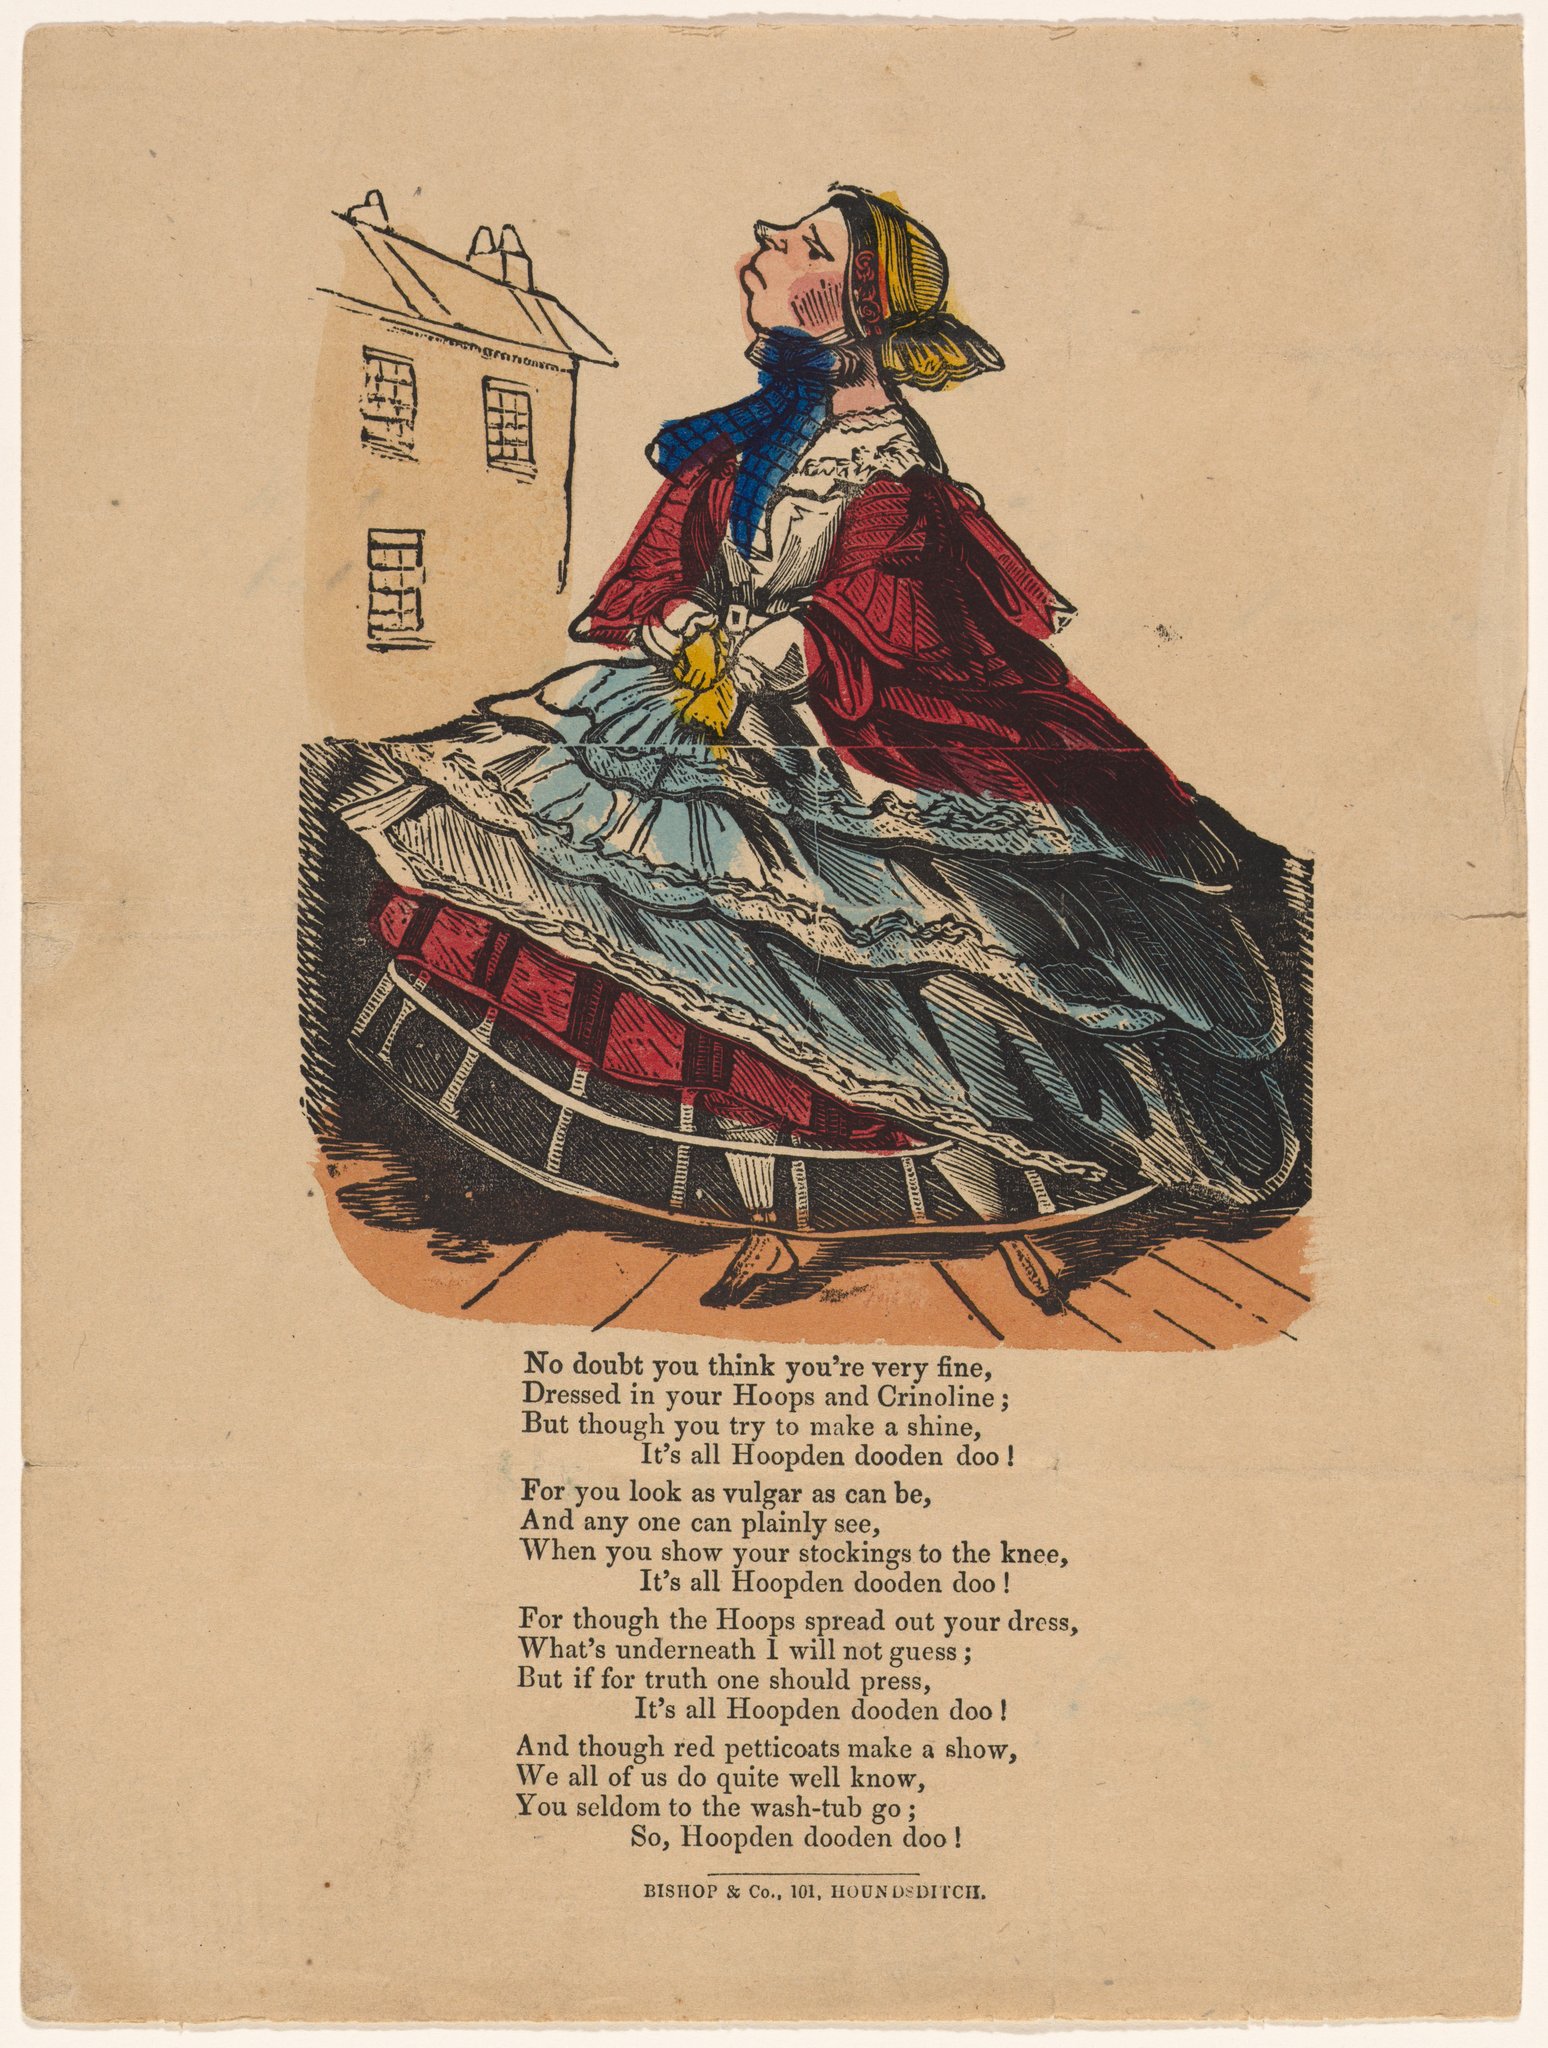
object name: valentine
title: Comic Valentine (Crinoline)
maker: Anonymous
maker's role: artist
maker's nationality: british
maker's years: 1800-1899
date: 1840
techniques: hand coloring, engraving